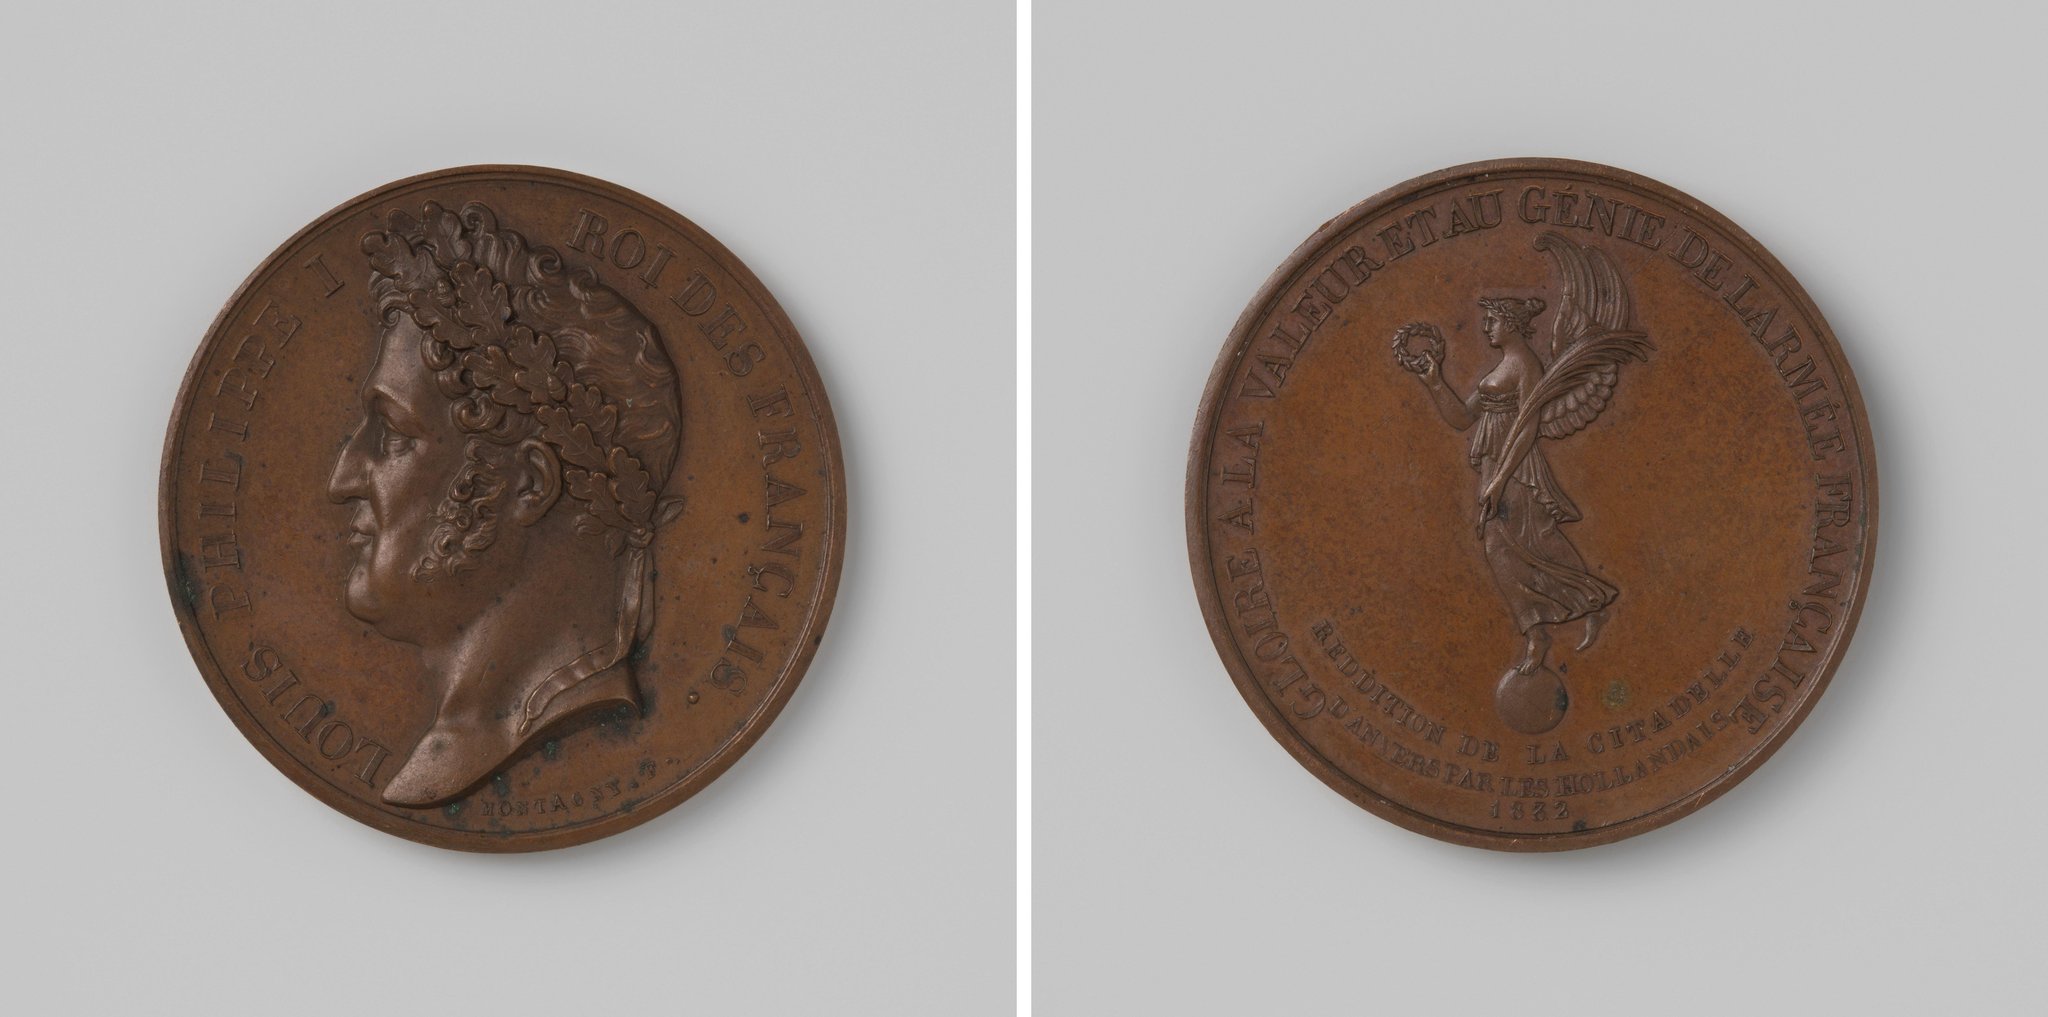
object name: history medal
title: Verovering van de citadel van Antwerpen, ter ere van Lodewijk Filips, koning der Fransen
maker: jean pierre montagny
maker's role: sculptor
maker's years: 1789-1862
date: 1832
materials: bronze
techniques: striking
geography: france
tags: lodewijk filips i (koning van frankrijk)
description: Bronzen penning. Voorzijde: borststuk man met eikenkrans binnen omschrift. Keerzijde: gevleugelde Overwinning met lauwerkrans en palmtak, staande op wereldbol binnen omschrift.